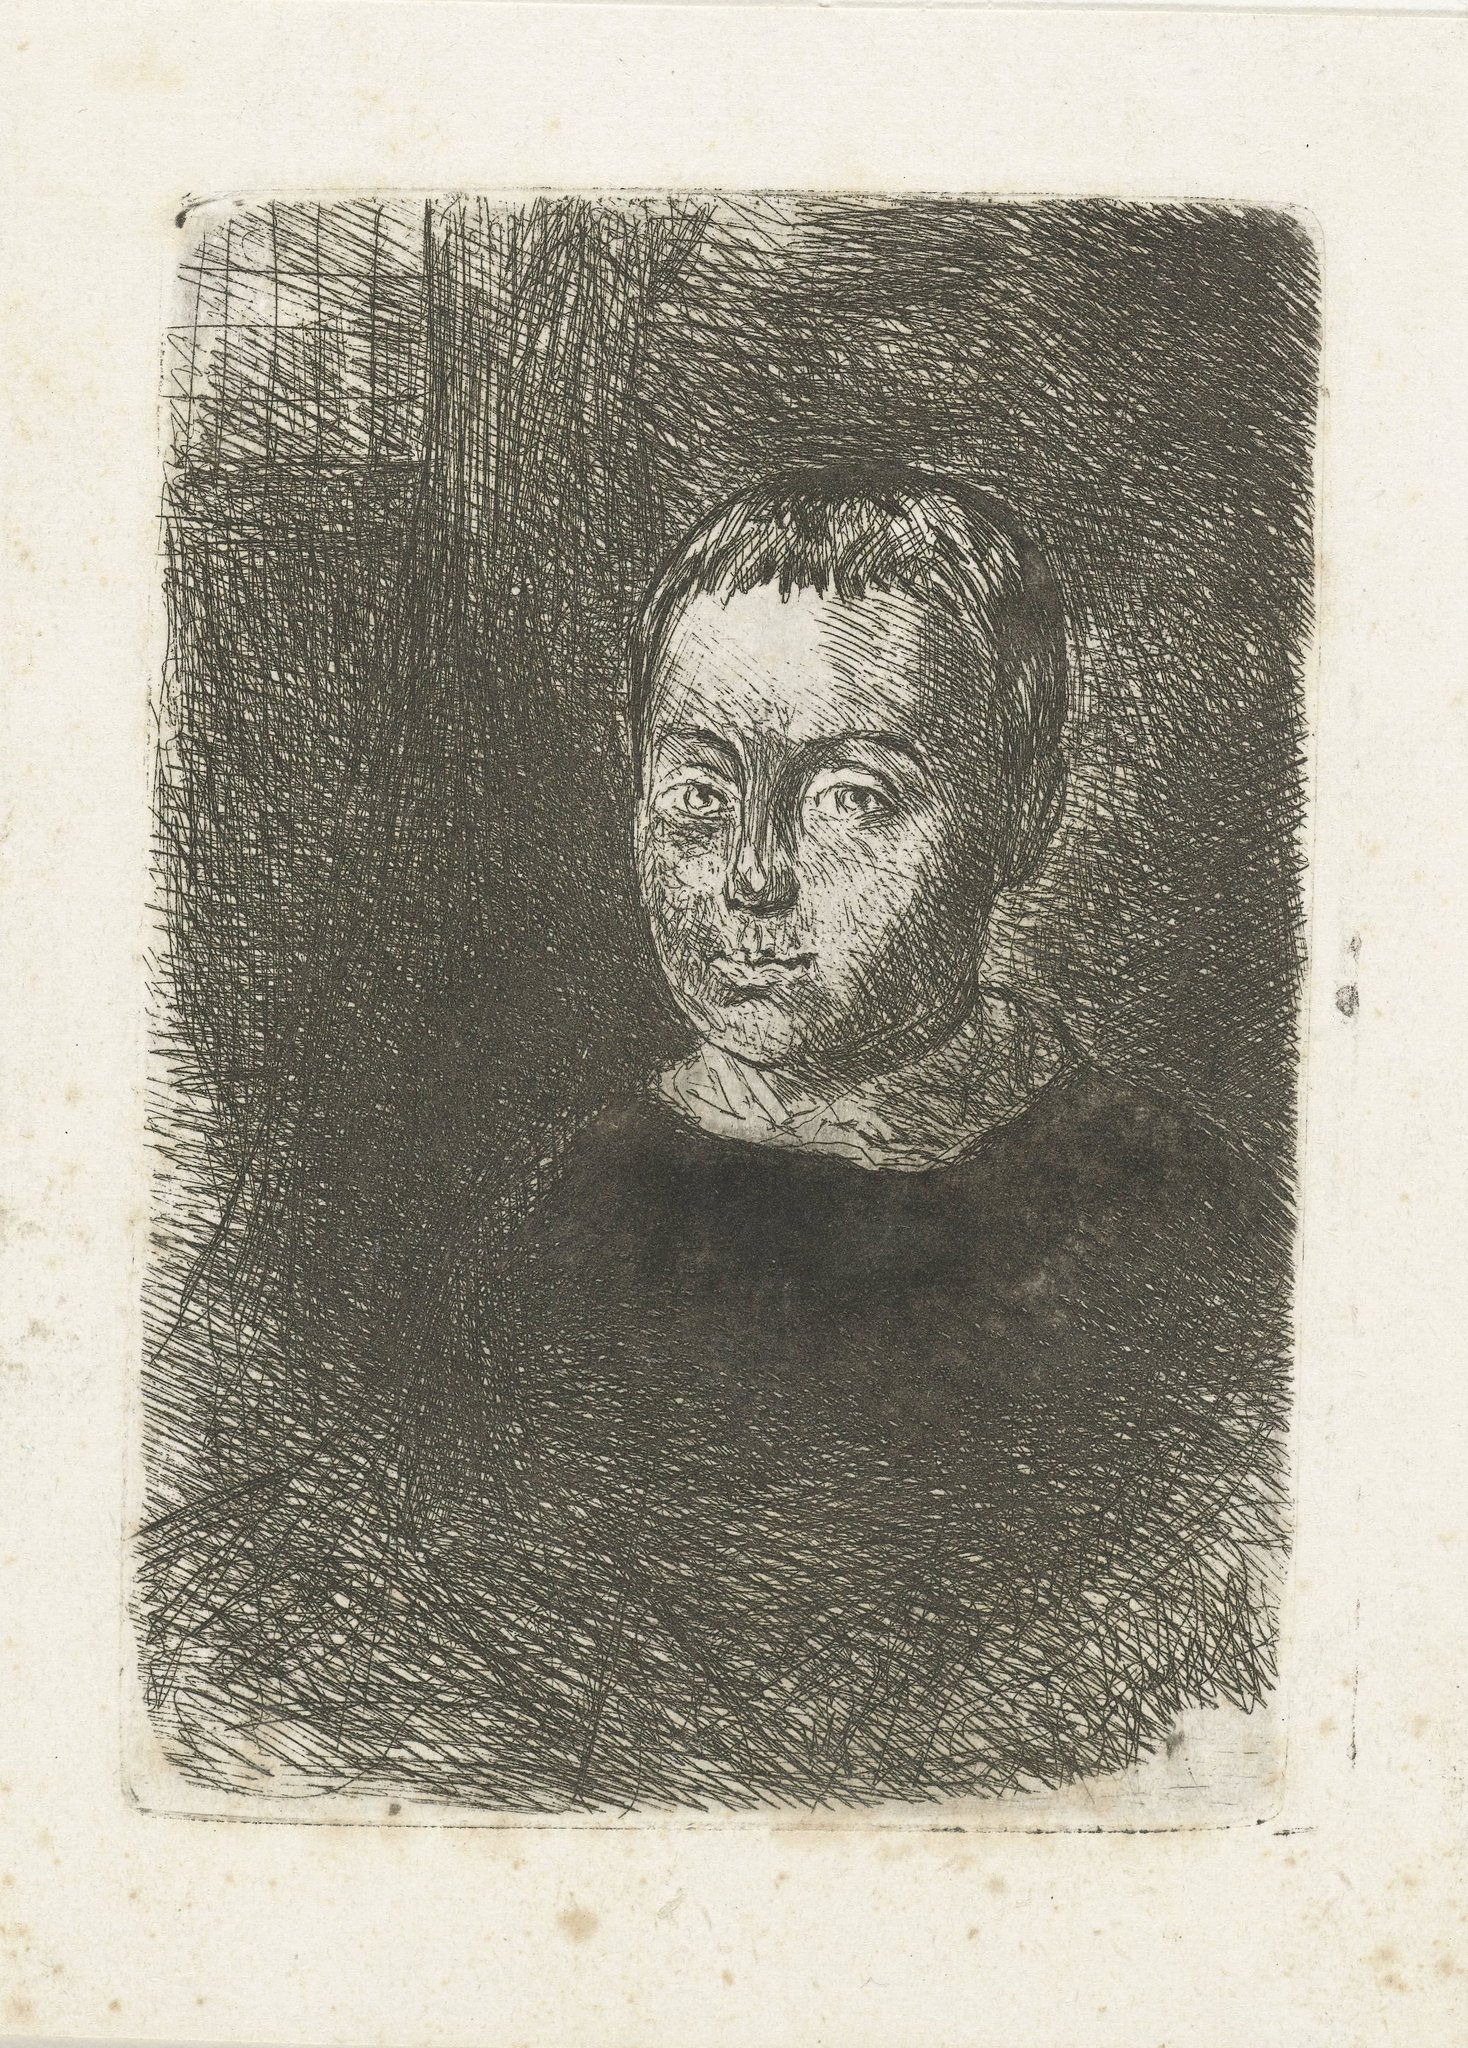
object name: print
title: Portret van een jongen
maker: huib van hove bz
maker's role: painter, print maker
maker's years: 1814-1867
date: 1824-1864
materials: paper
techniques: etching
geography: low countries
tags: portrait, self-portrait of artist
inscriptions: collector's mark: Lugt 2228, collector's mark: Lugt 1485, inscription: ‘I van hove’